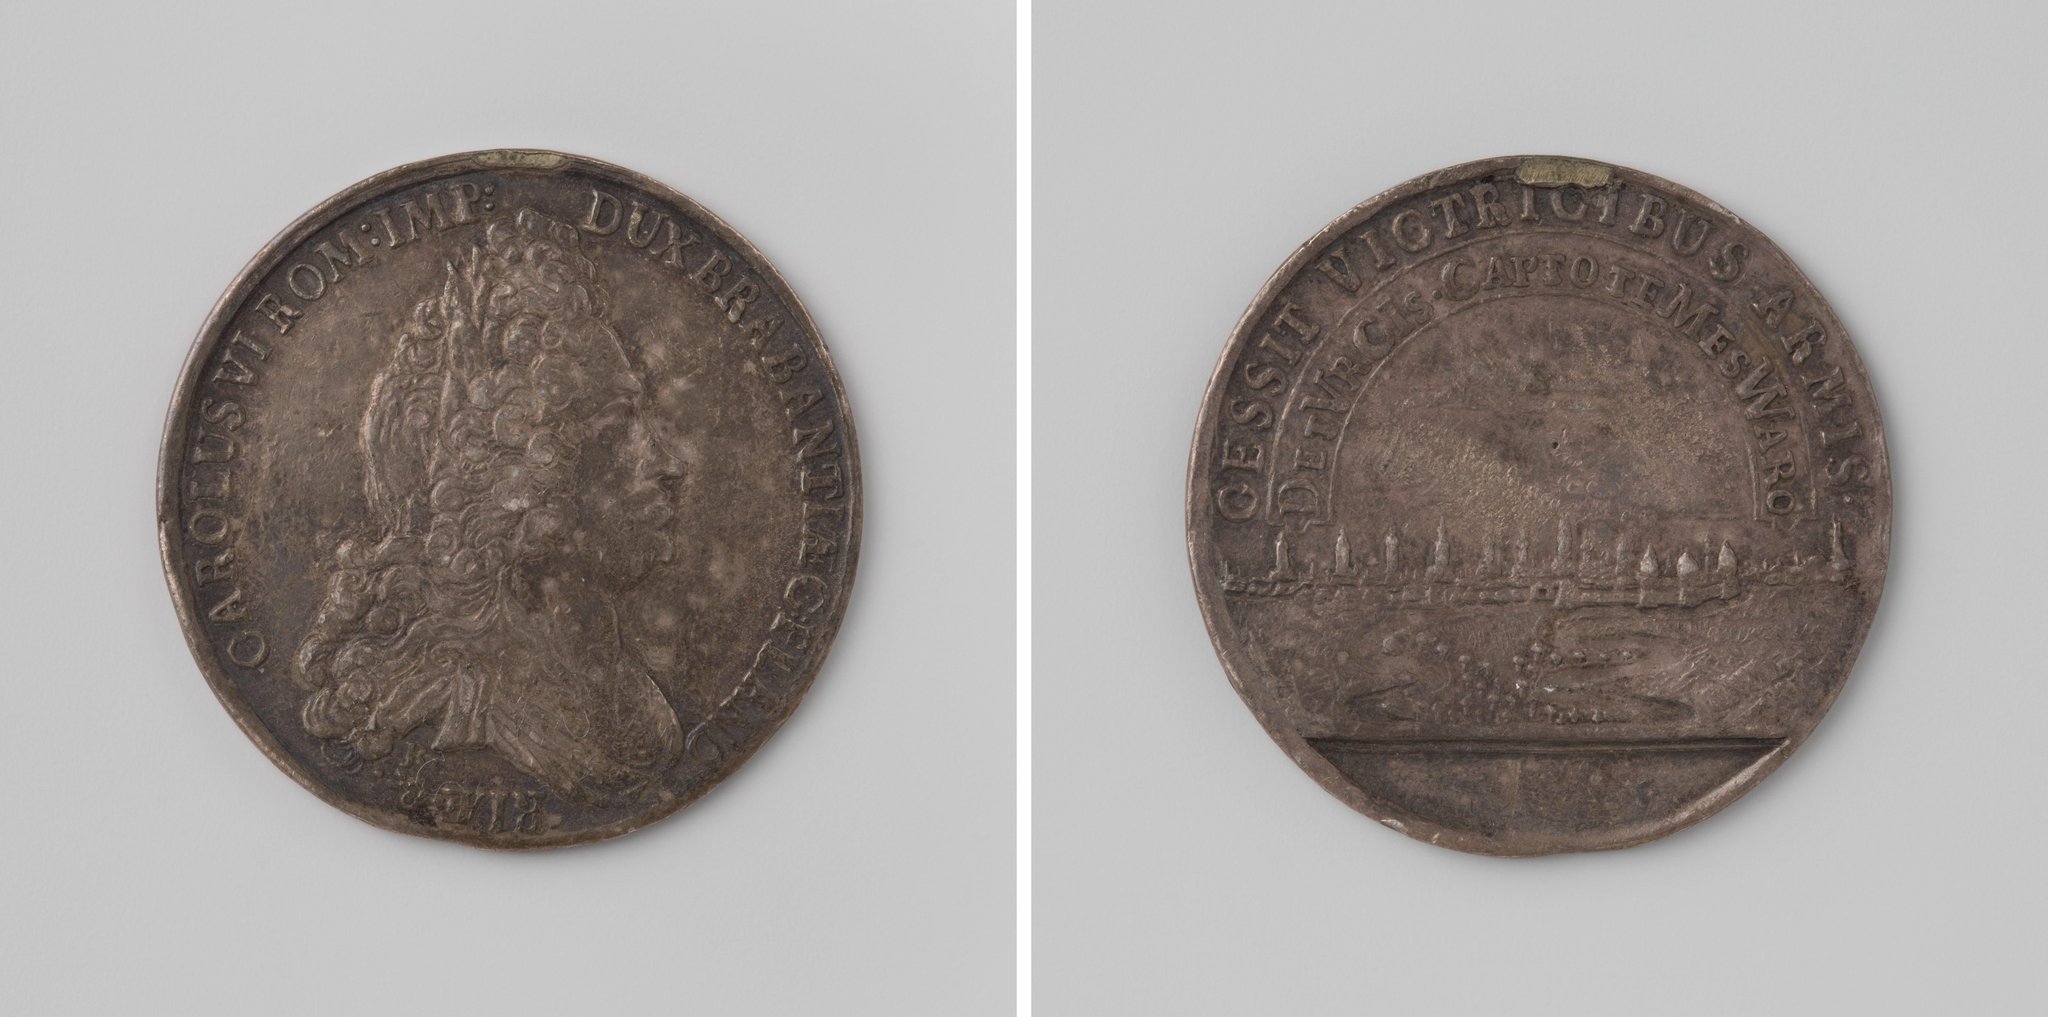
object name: history medal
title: Verovering van Temesvar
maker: philippe roëttiers (ii)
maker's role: medailleur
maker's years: 1640-1718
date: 1716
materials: silver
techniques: striking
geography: antwerp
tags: vienna, charles vi (holy roman emperor)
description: Zilveren penning. Voorzijde: borststuk man met lauwerkrans binnen omschrift. Keerzijde: gezicht op stad Temesvar aan rivier binnen omschrift